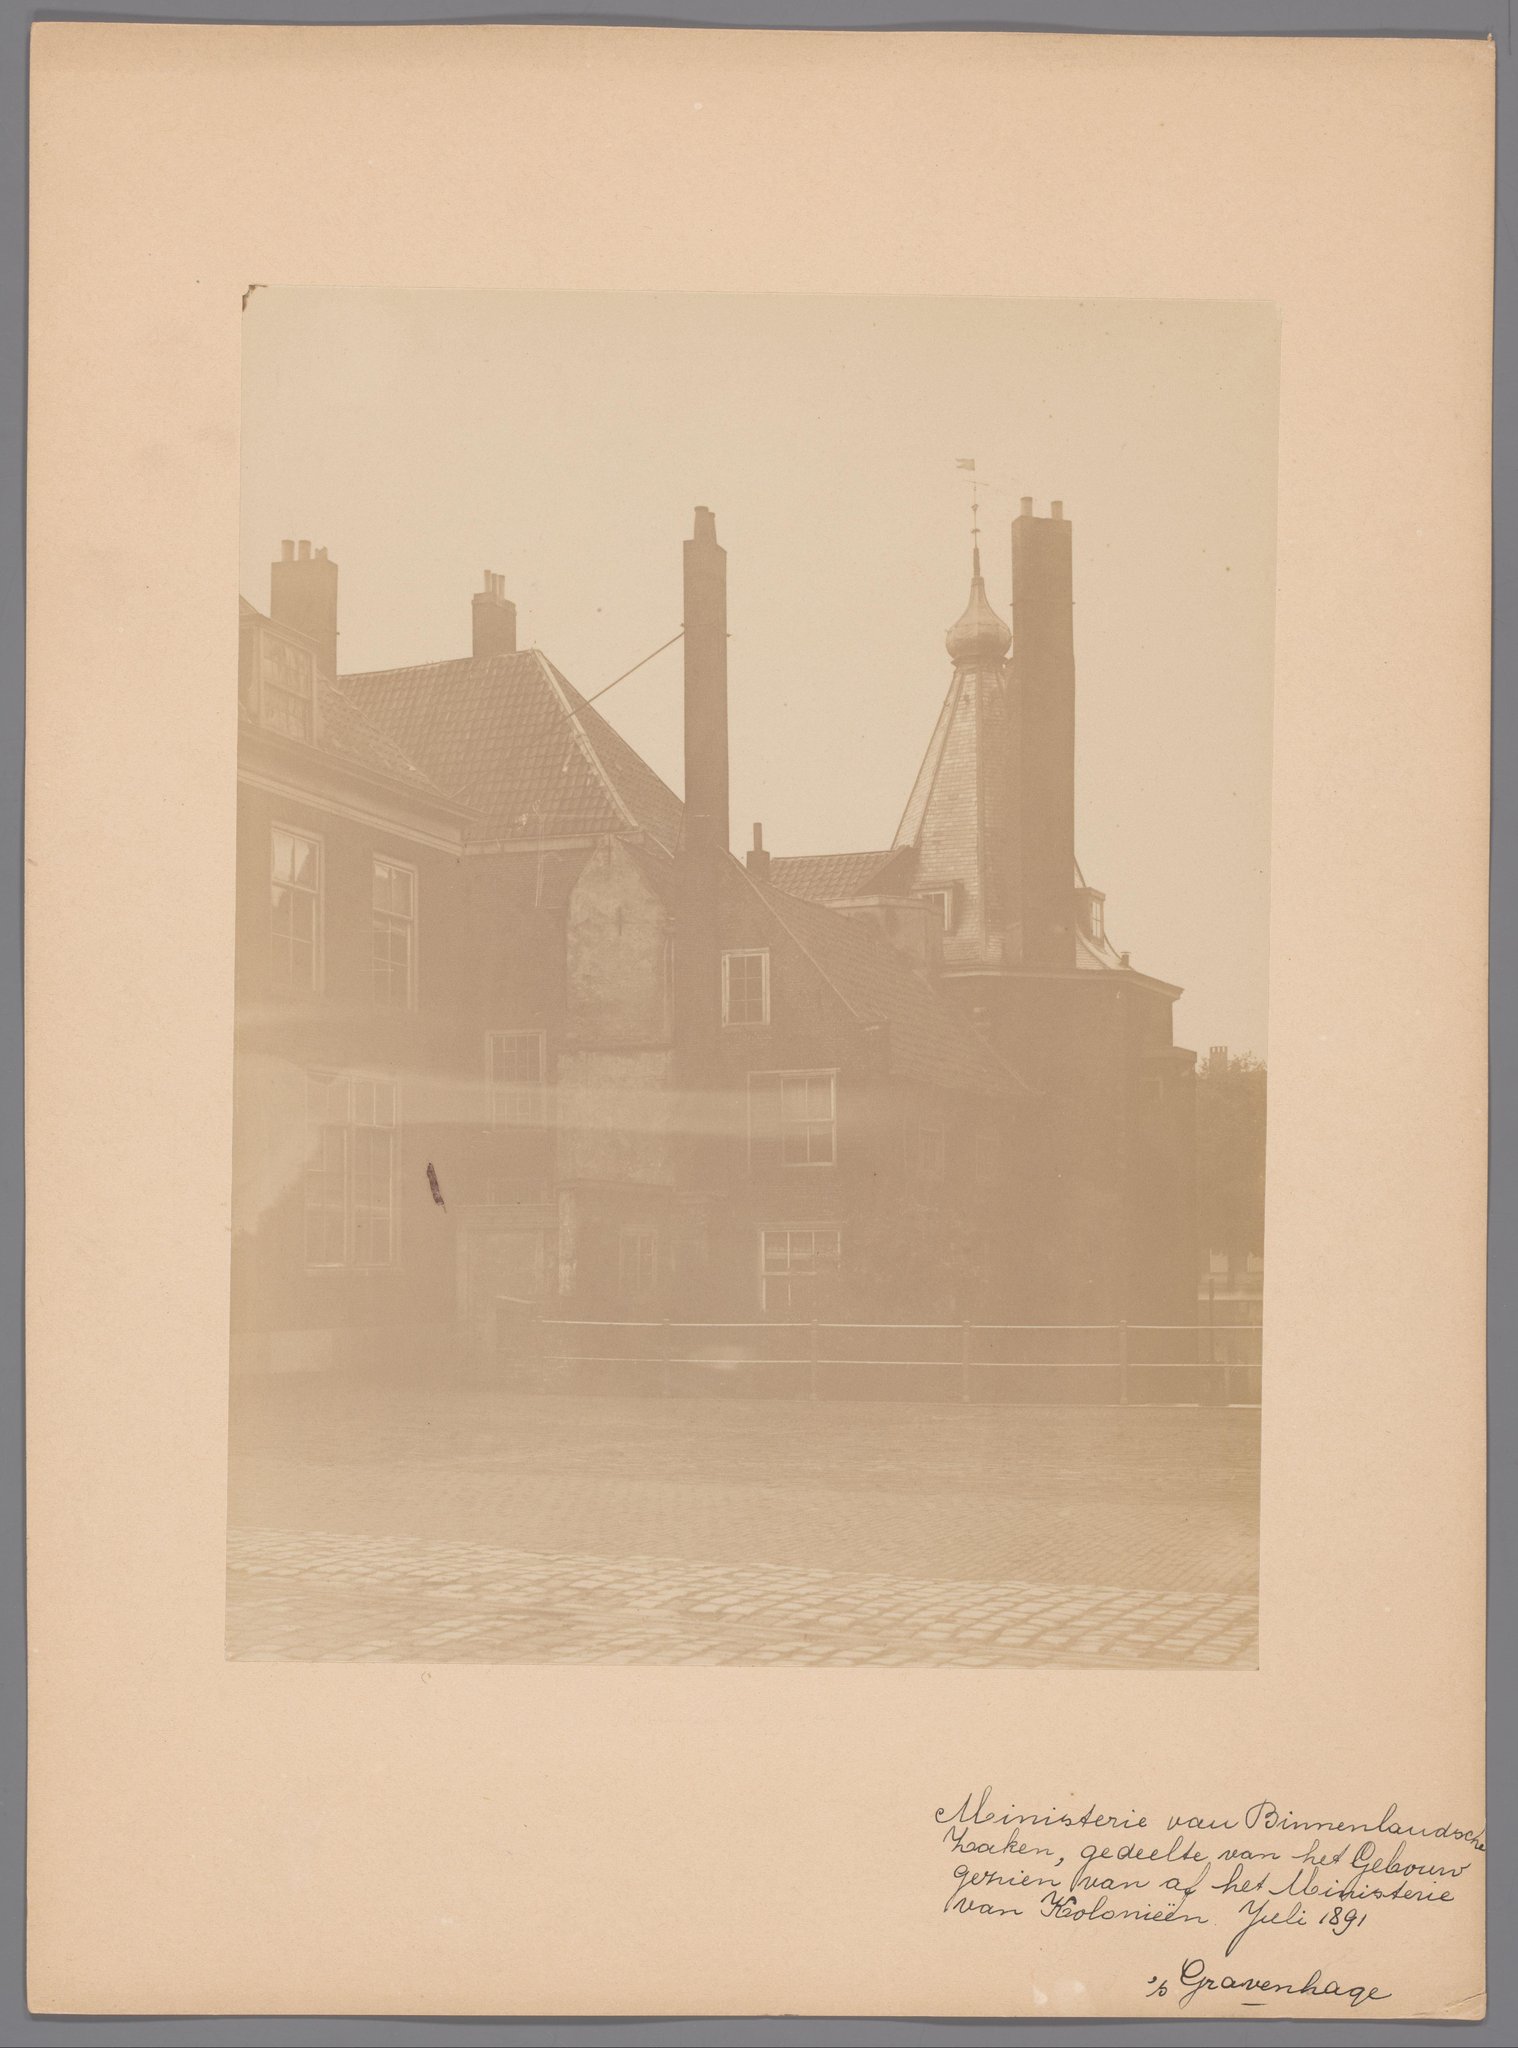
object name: photograph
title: Voormalig ministerie van binnenlandse zaken te Den Haag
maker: anoniem (monumentenzorg)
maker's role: fotograaf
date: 1891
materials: cardboard, photographic support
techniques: albumen print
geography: the hague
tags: national government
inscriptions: annotation: ‘Een gedeelte van het gebouw, Ministerie van Binnenlandsche zaken gezien van af het Ministerie van kolonieën/ Juli 1891’, annotation: ‘Ministerie van Binnenlandsche Zaken, gedeelte van het gebouw gezien van af het Ministerie van Kolonieën. Juli 1891/ 's Gravenhage’